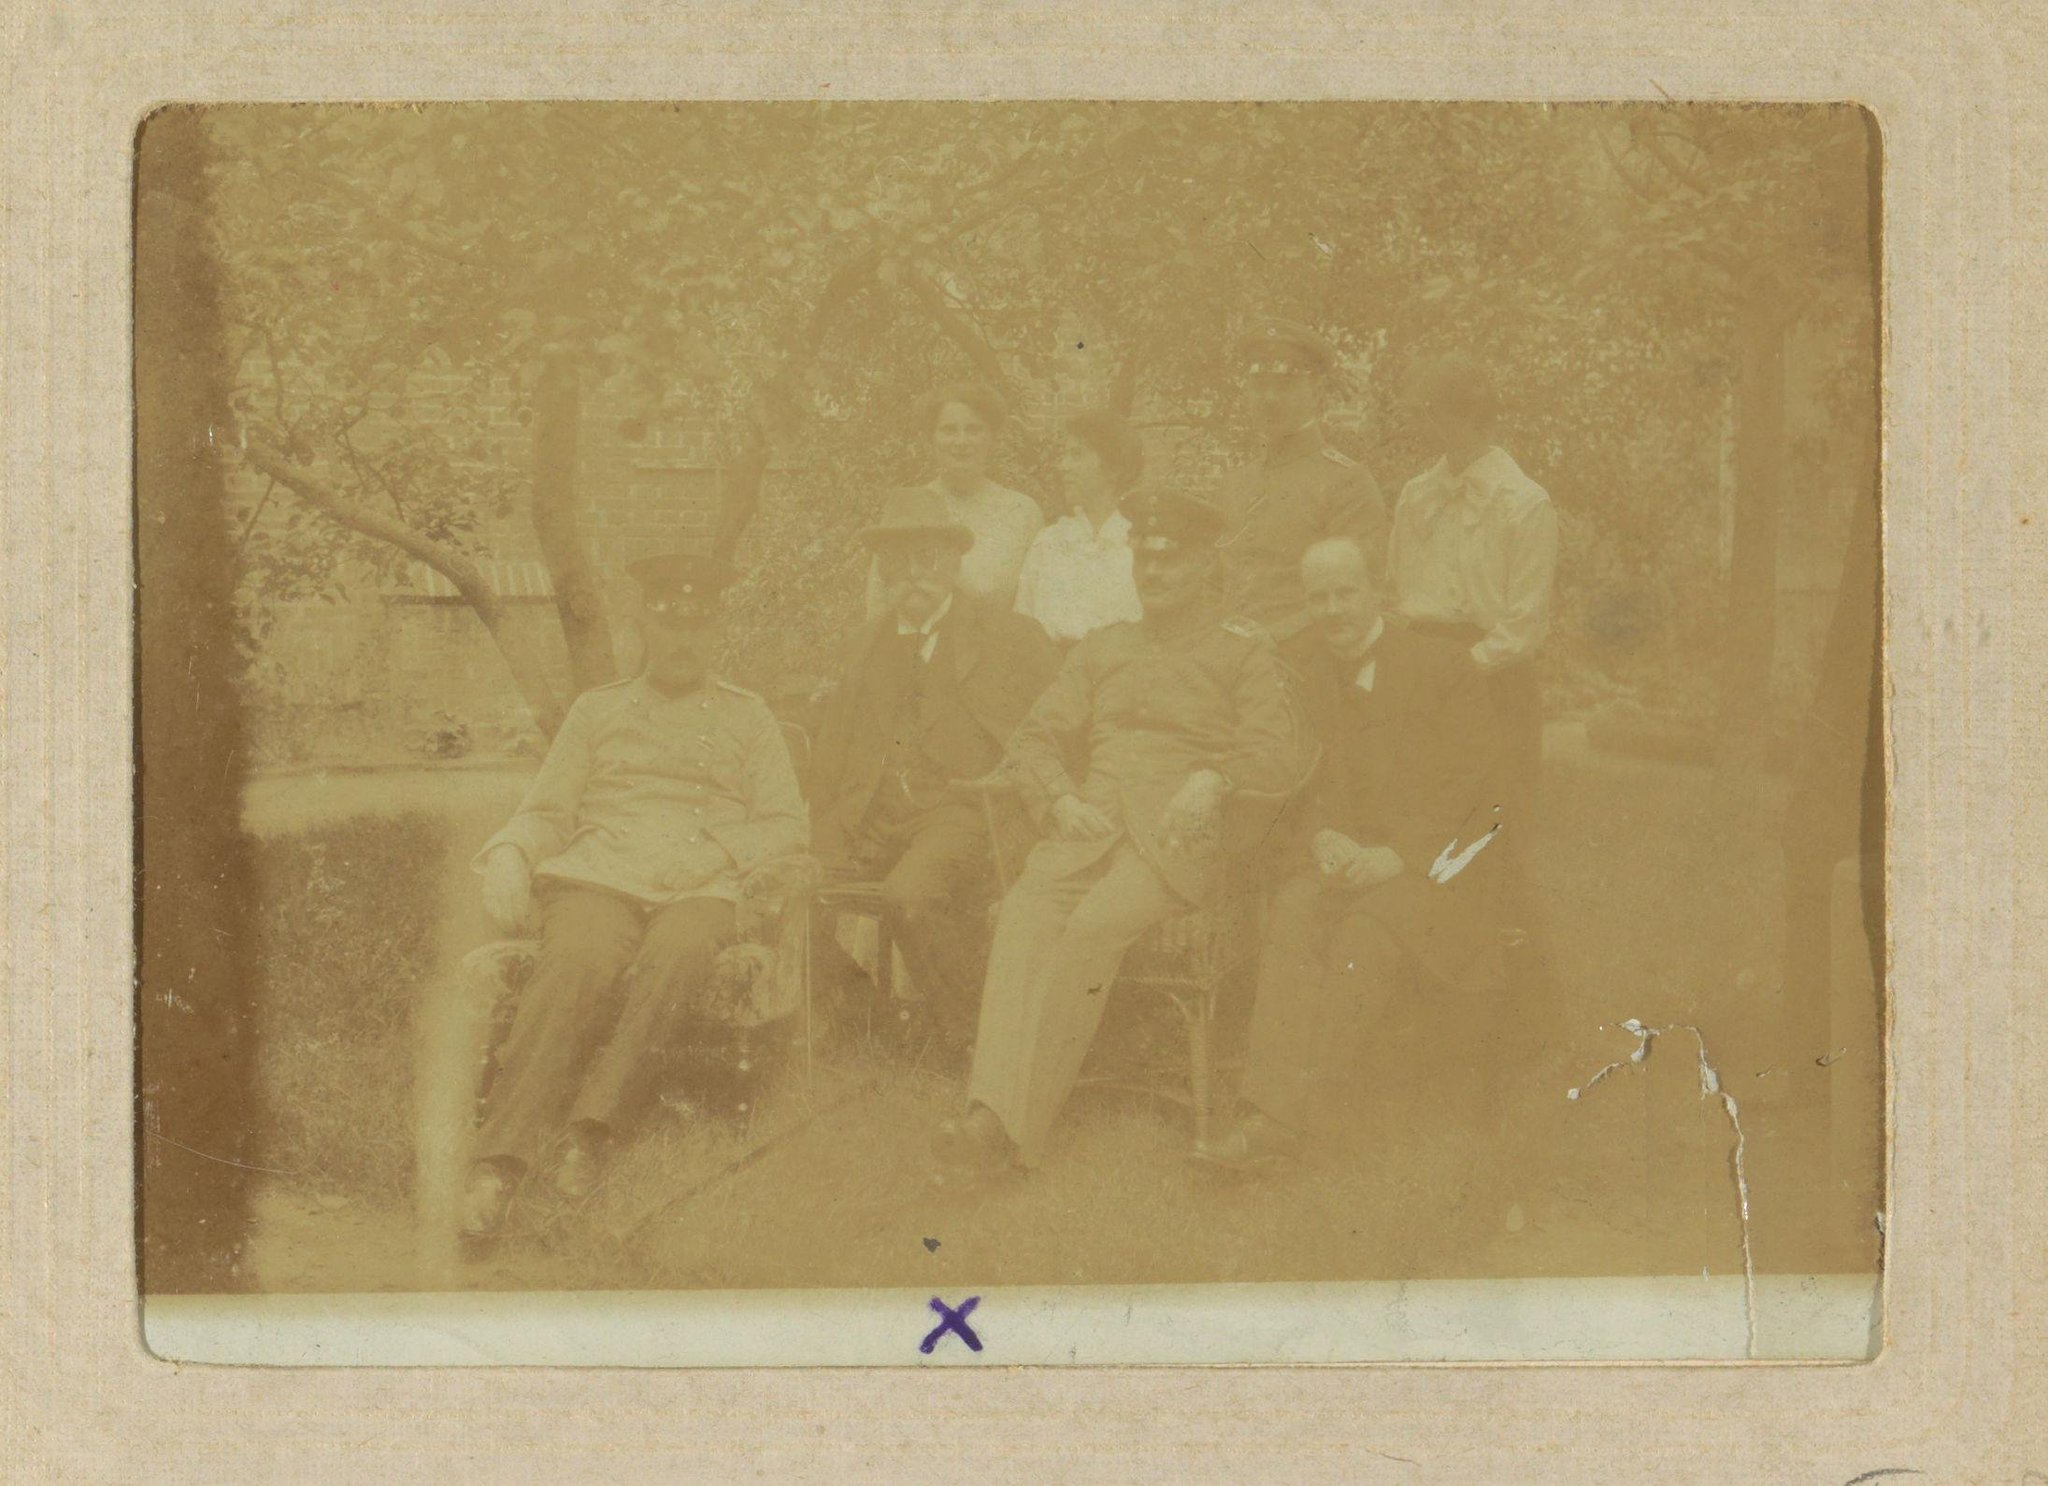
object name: photograph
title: Exterieur van de gevangenis in Cassel-Wehlheiden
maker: Anonymous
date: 1890-1910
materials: cardboard, paper, photographic support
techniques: gelatin silver print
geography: kassel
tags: prison, jail, fence, wall, paling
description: Onderdeel van Fotoalbum van Carl Heinrich Fliegenschmidt, gevangenisdirecteur te Oslebshausen.